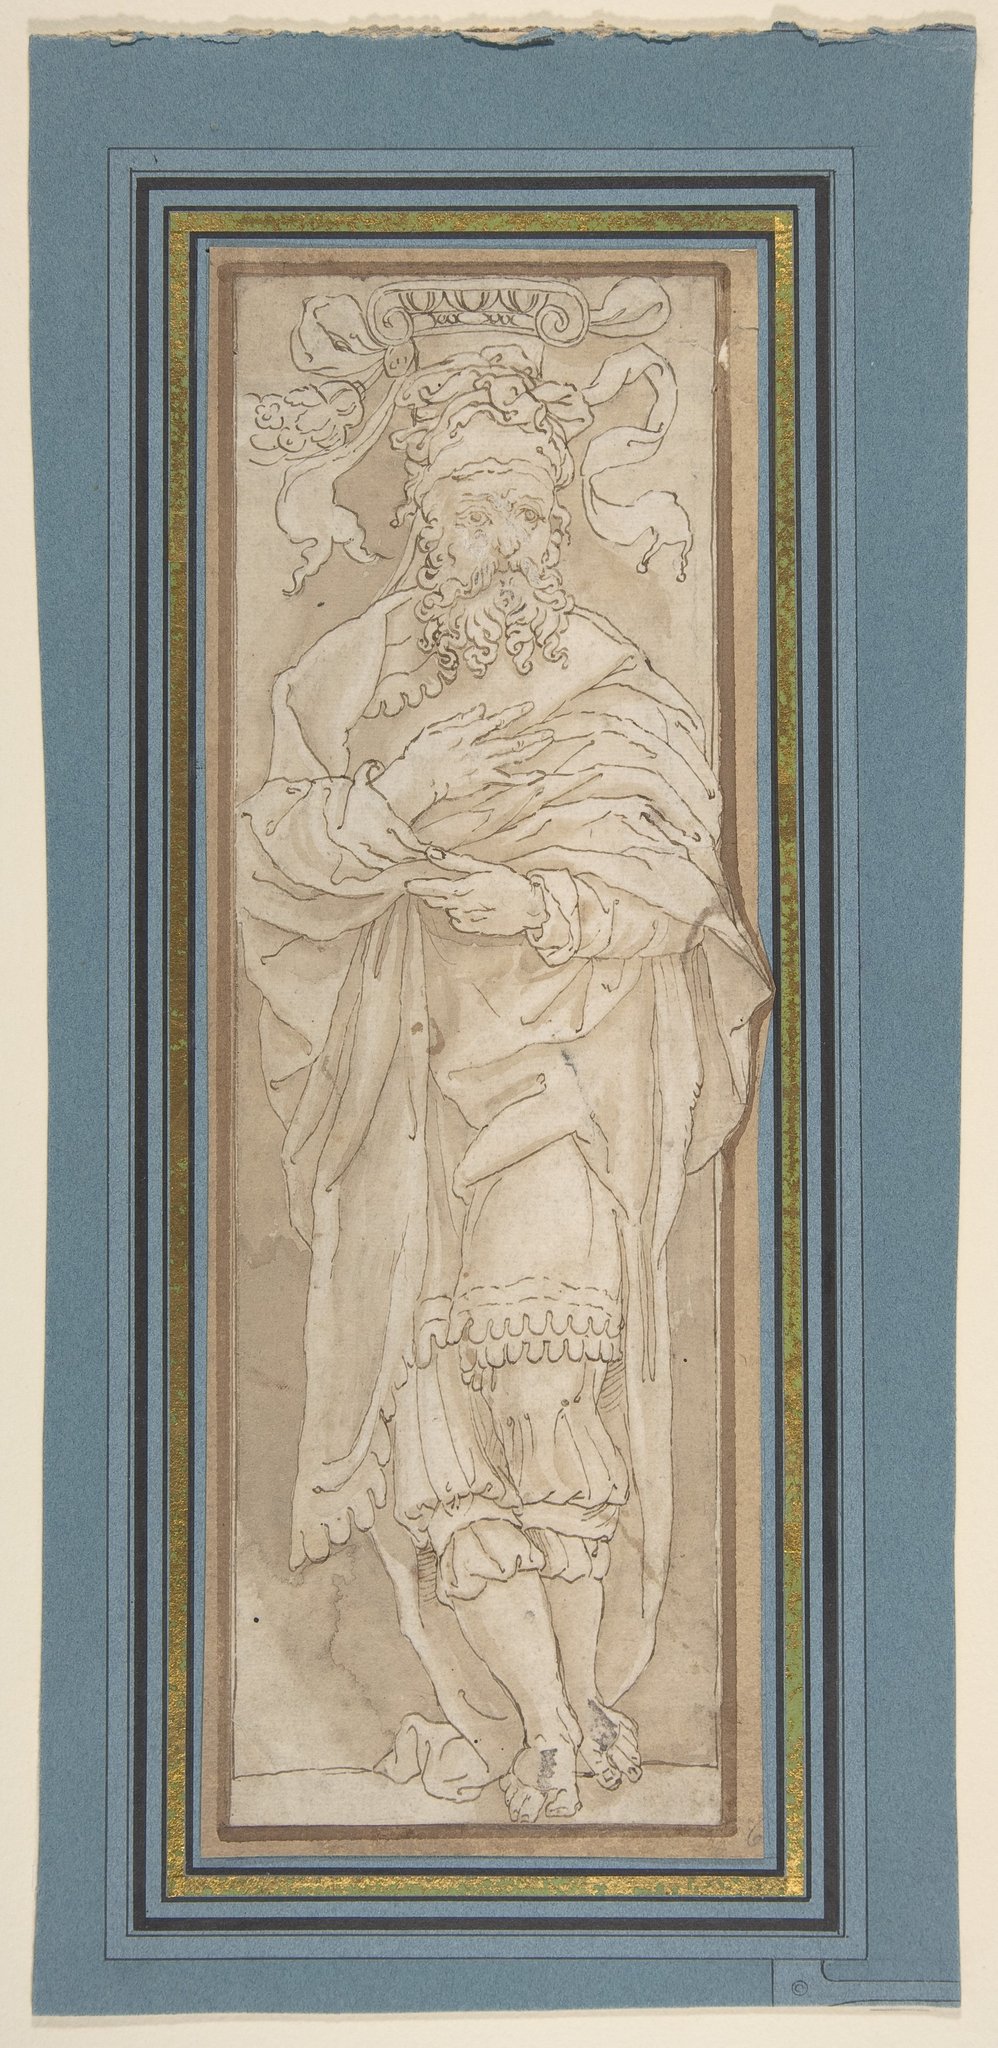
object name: drawing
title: Caryatid, after Perino del Vaga drawing in Albertina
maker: anonymous, netherlandish, 16th century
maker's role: artist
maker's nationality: netherlandish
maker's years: 1500-1600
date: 1520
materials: ink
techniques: pen, wash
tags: caryatids,men